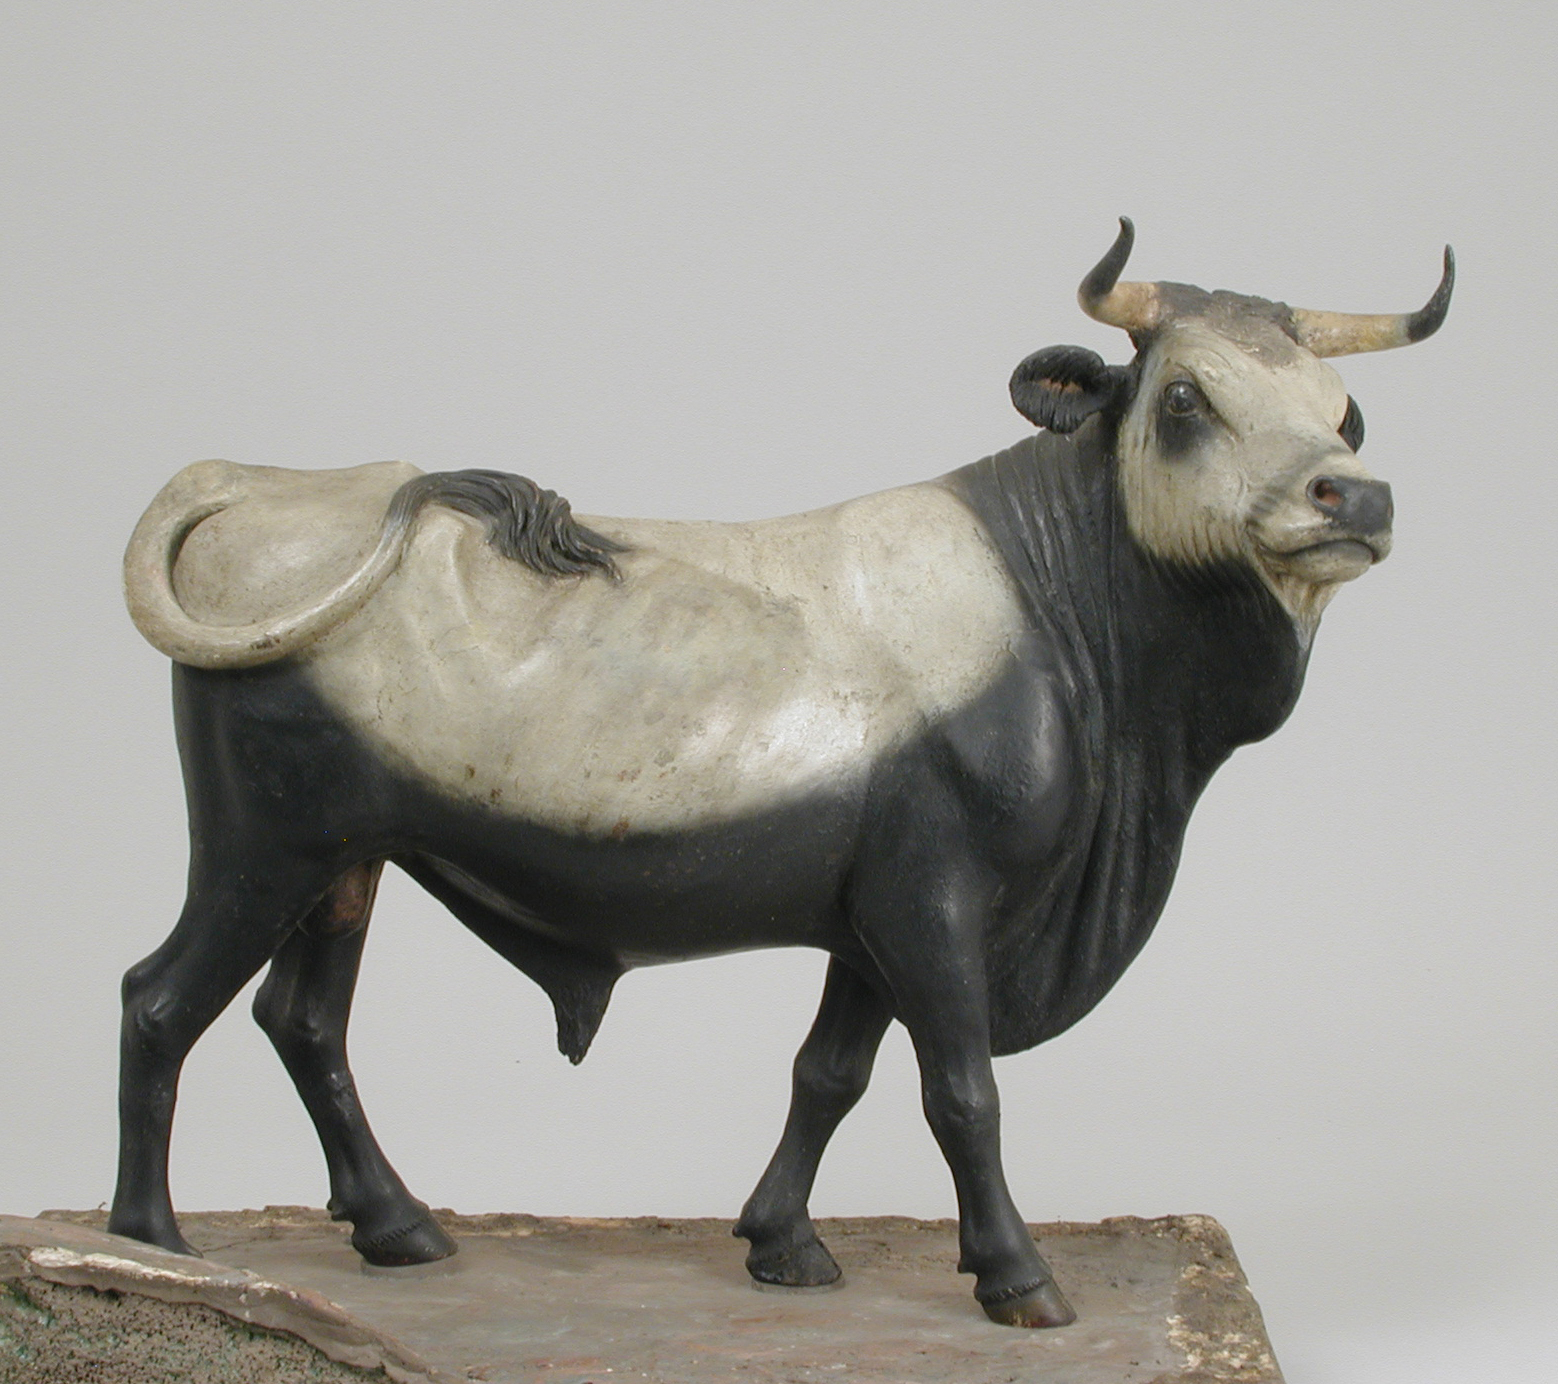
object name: crèche figure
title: Bull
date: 1701-1800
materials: terracotta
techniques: polychrome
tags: bulls